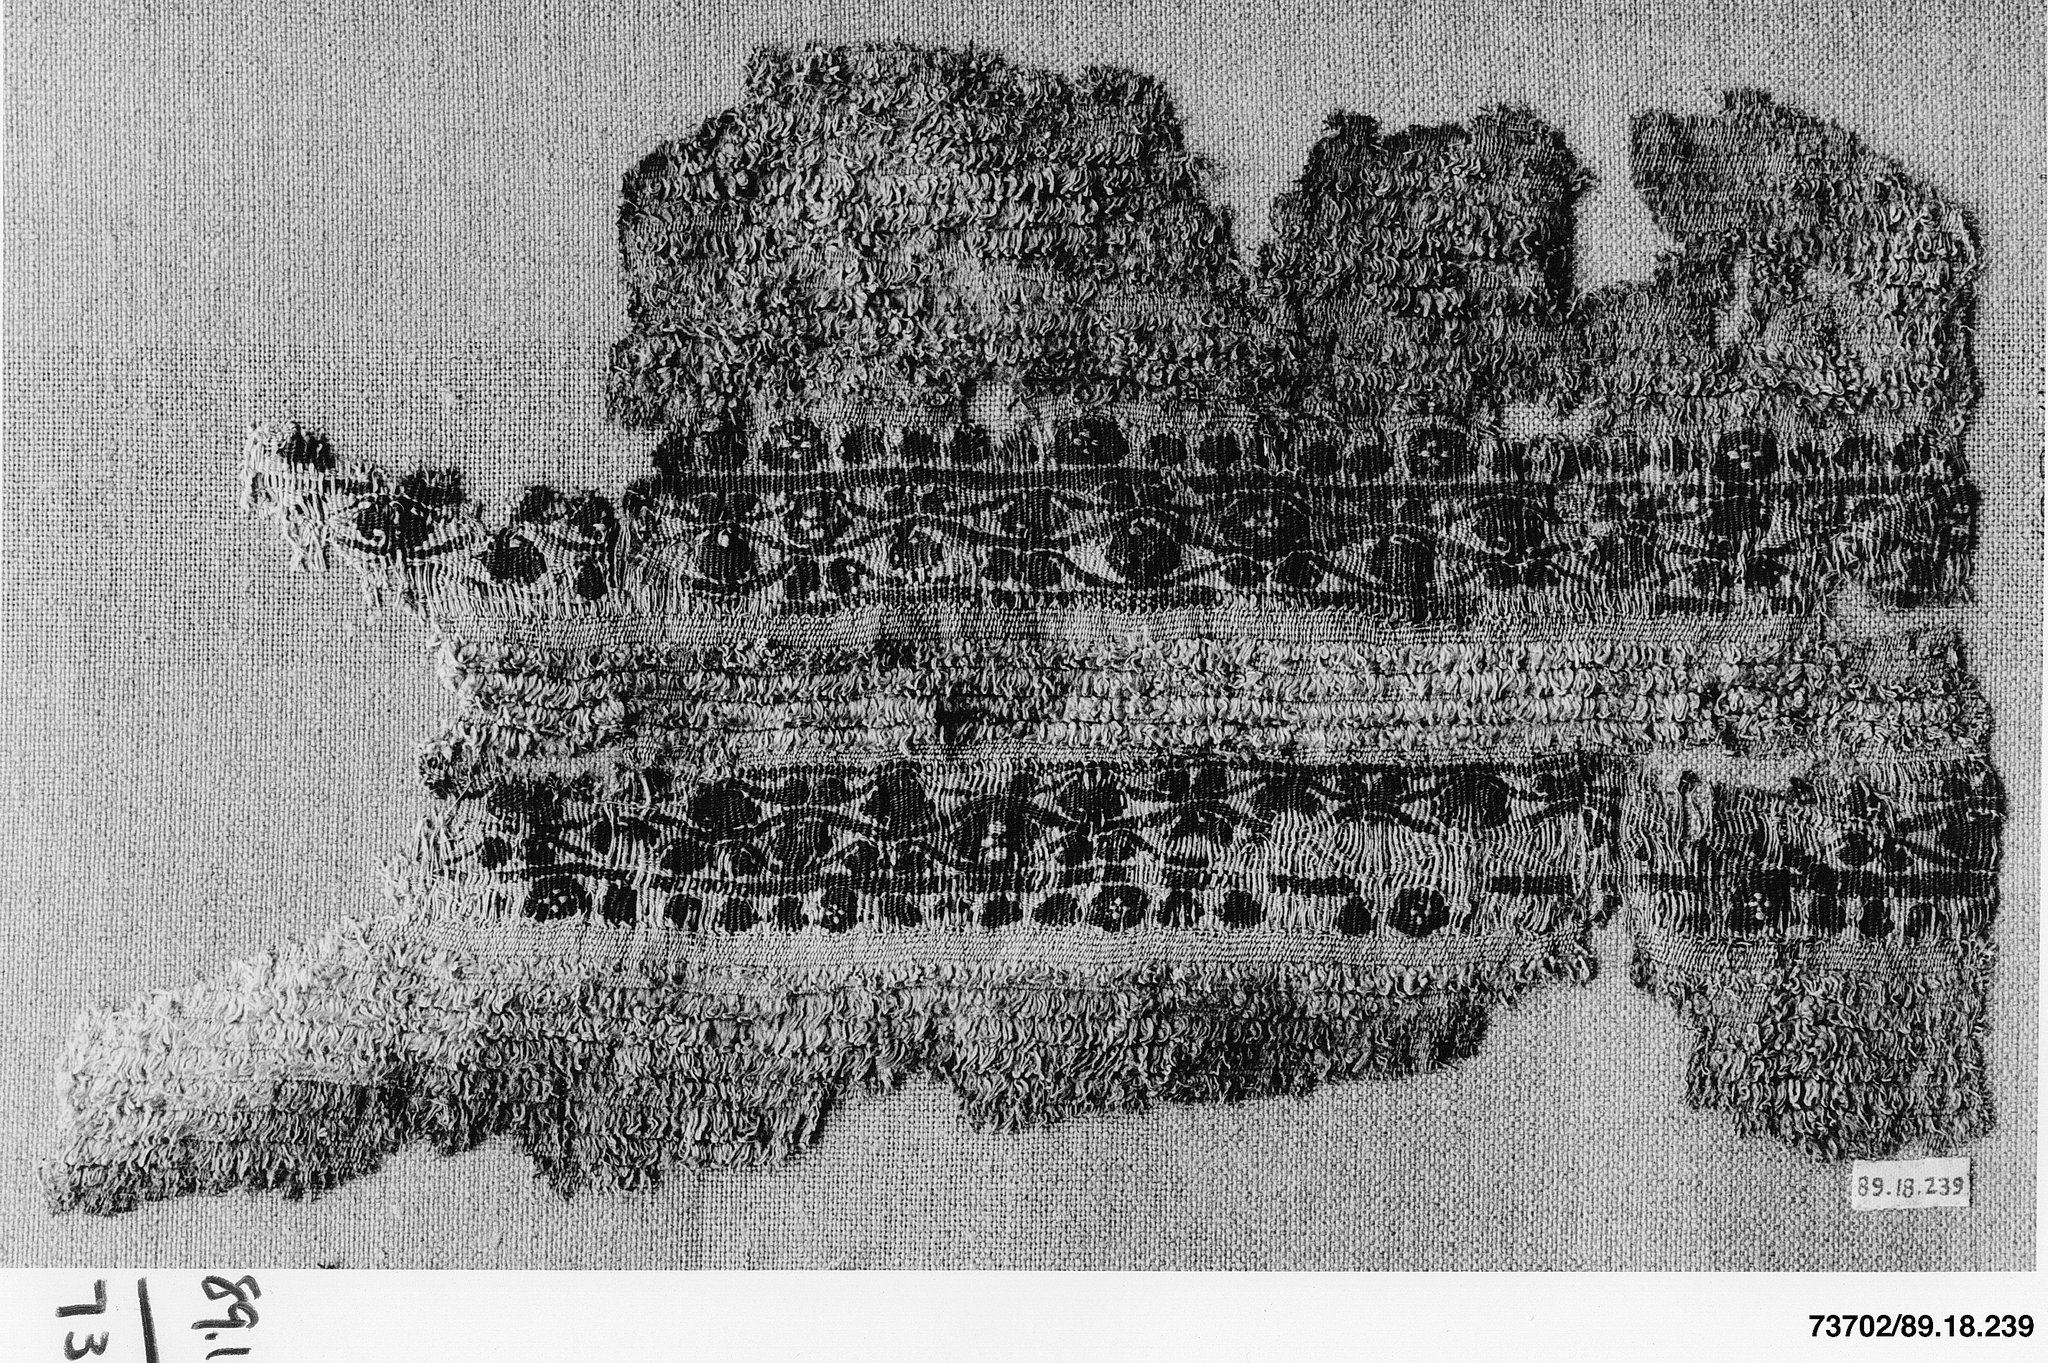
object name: textile fragment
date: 201-400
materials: linen, wool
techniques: weave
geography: egypt